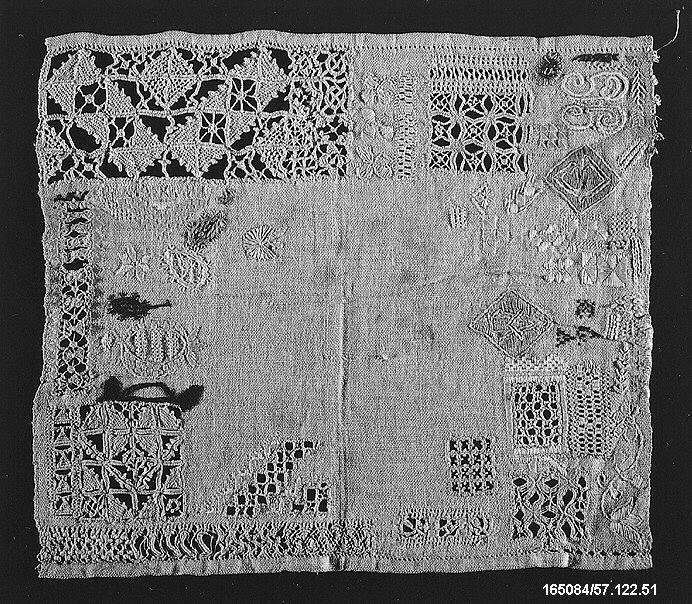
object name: sampler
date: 1801-1900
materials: linen, silk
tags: flowers,leaves